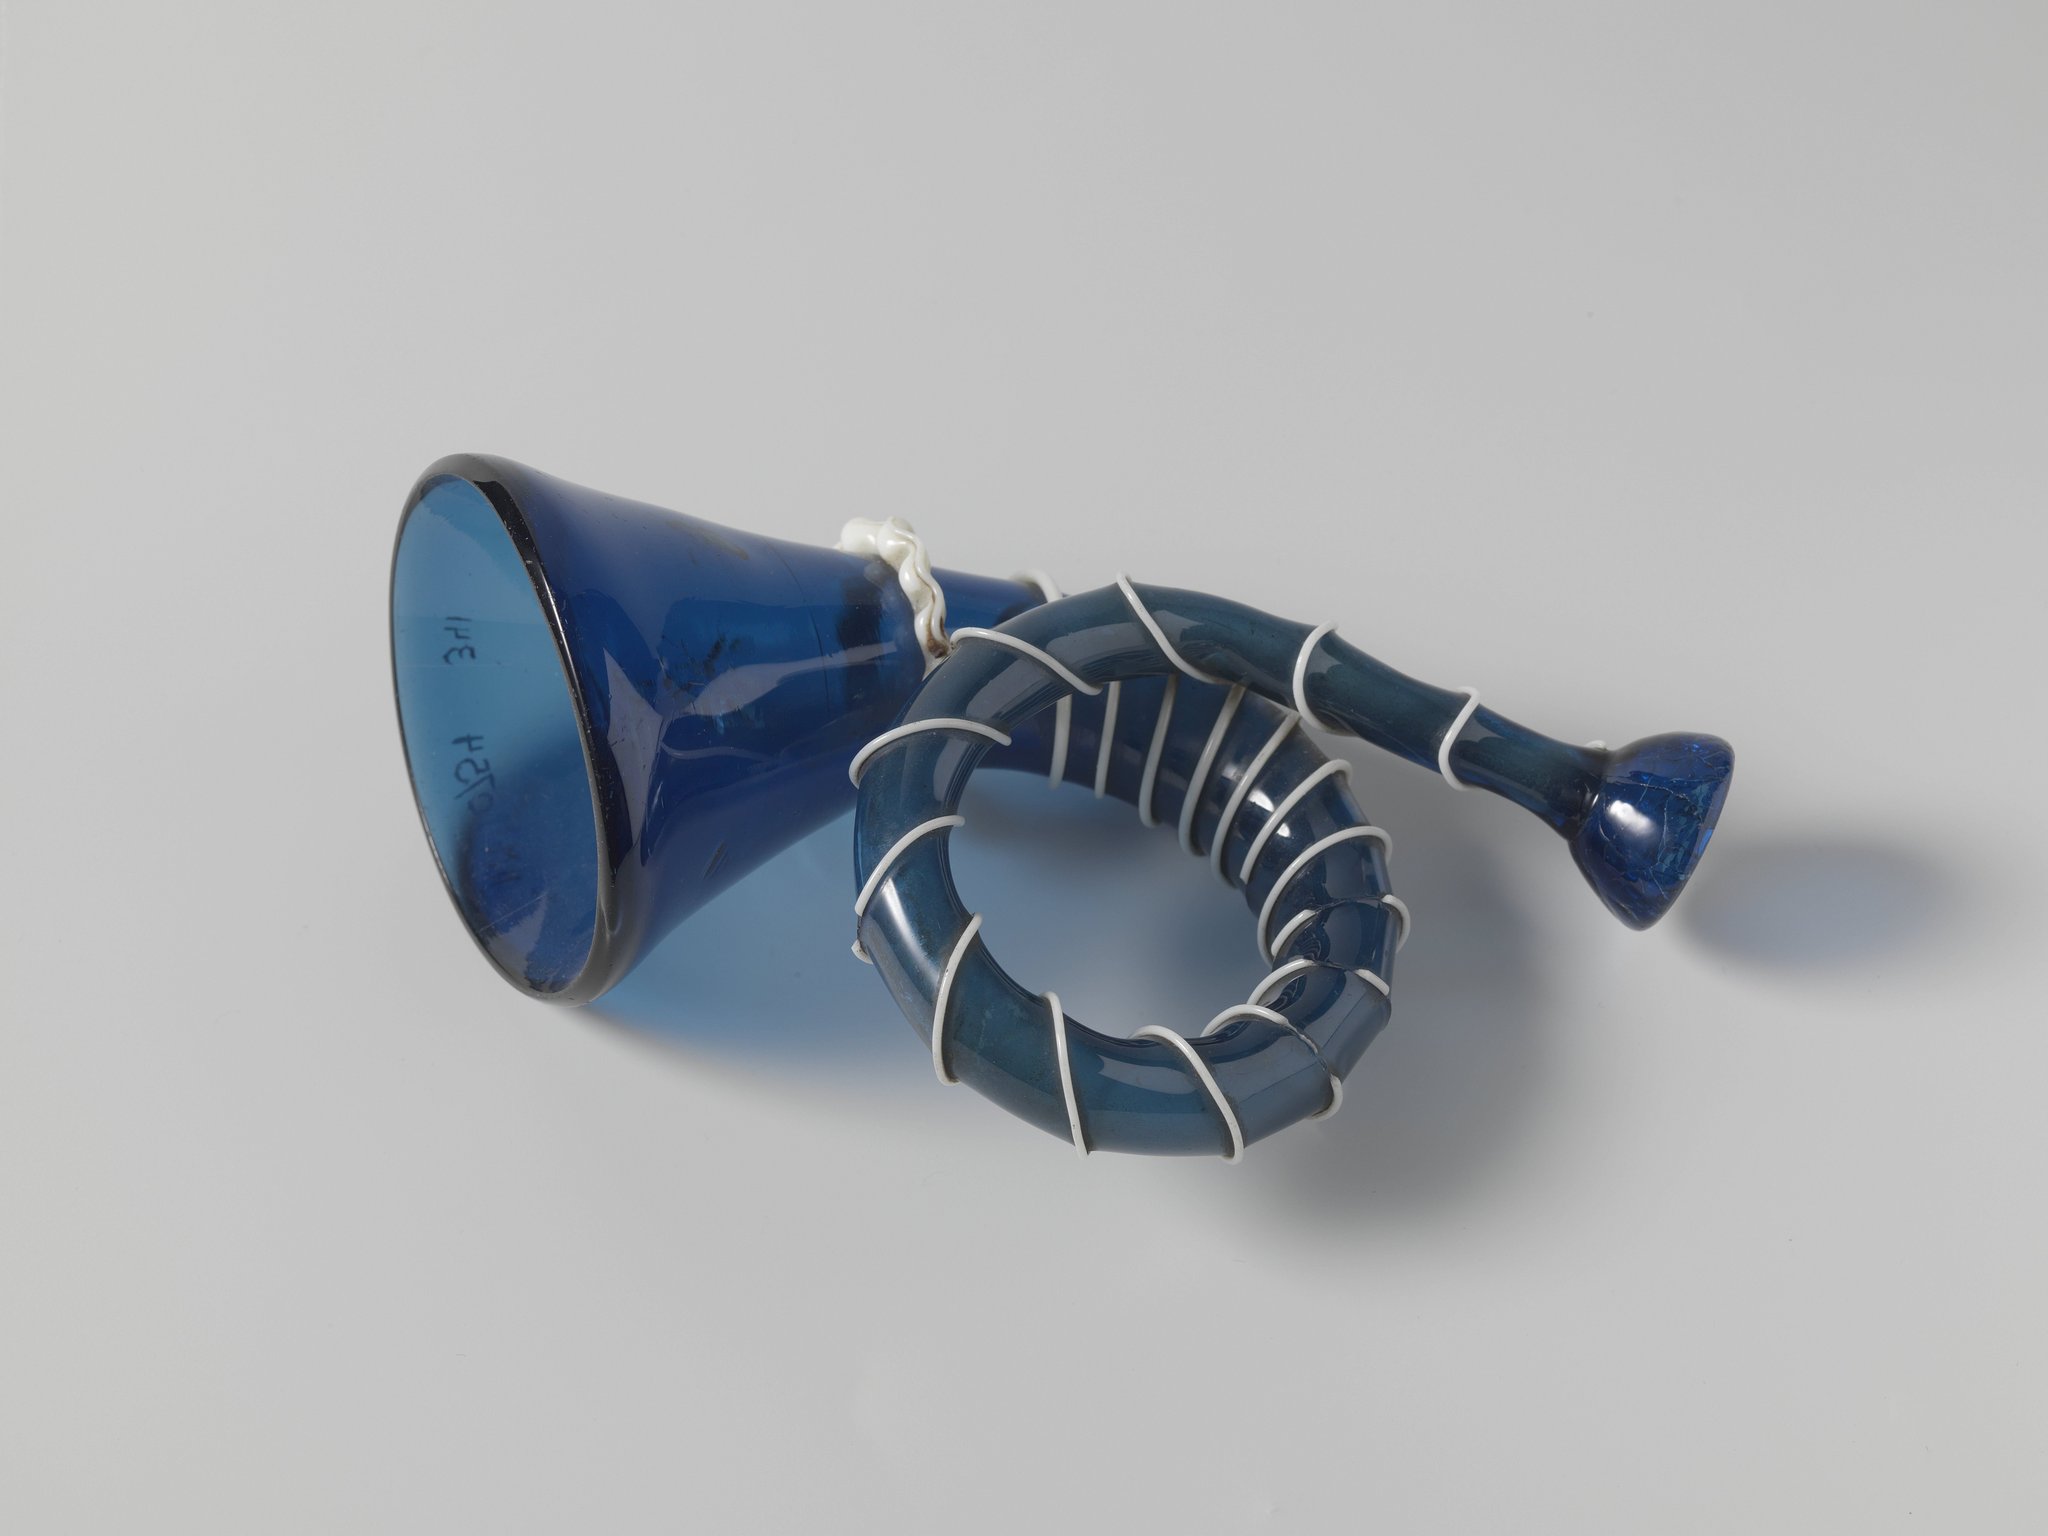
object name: hunting horn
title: Glass horn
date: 1700-1800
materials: glass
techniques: glassblowing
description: Gladde, rondgebogen buis, uitlopend in een wijde klankbeker, aan de smalle zijde een aangezet mondstuk. Rond de buis een witte draad, de overgang van de buis naar de klankbeker aangegeven door een gegolfde draad.